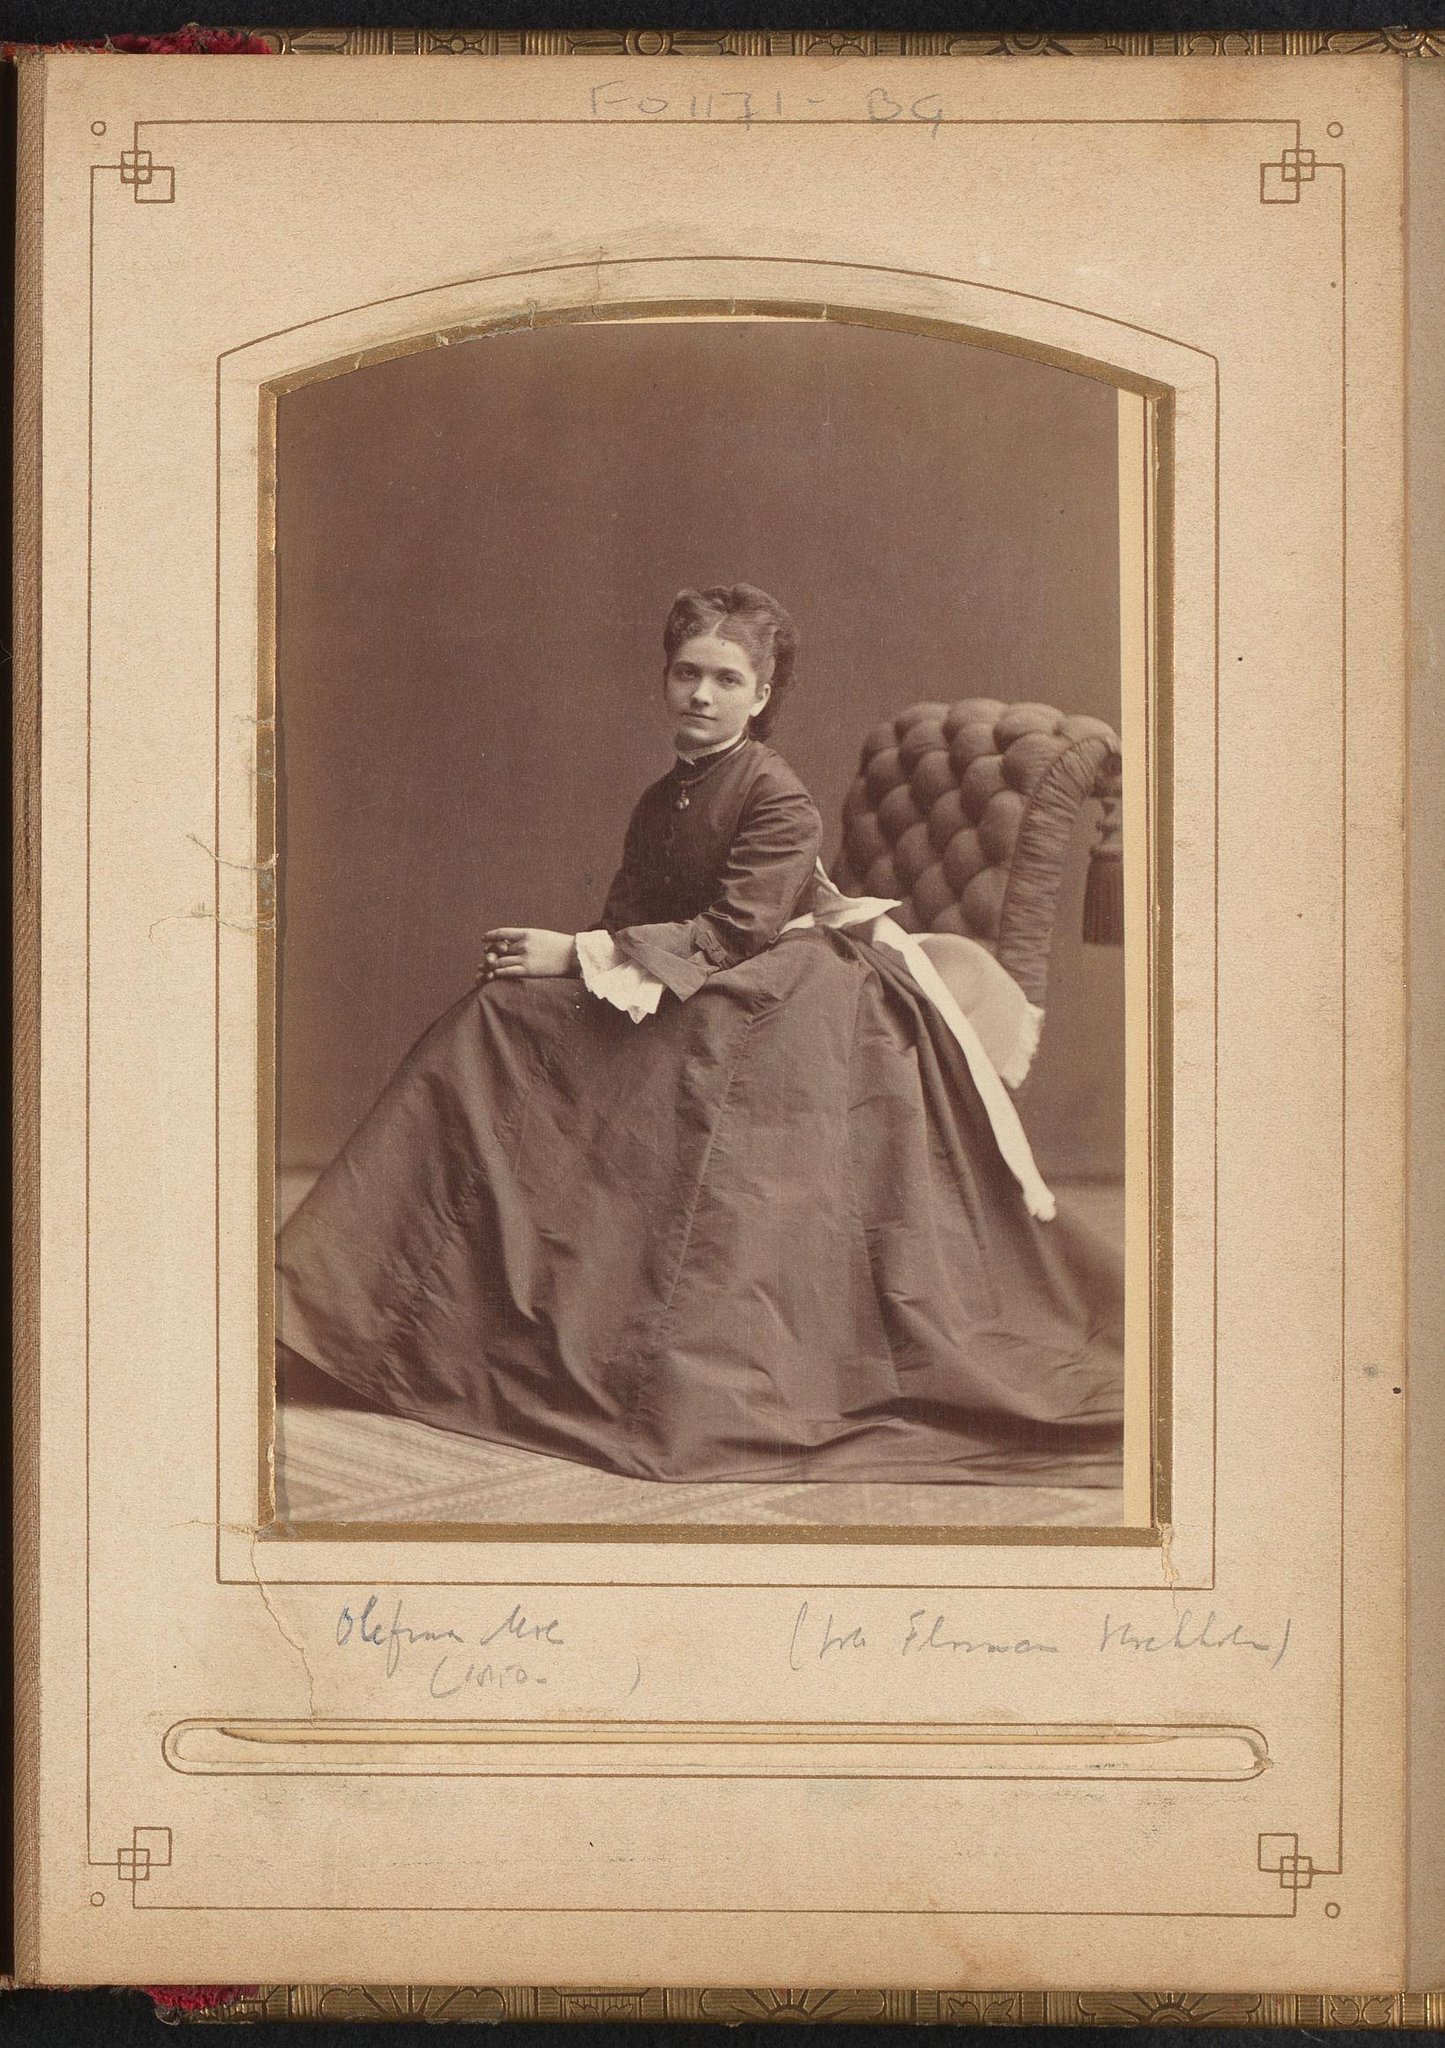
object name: album leaf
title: Portret van Olefine Moe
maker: gösta florman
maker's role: fotograaf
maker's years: 1831-1900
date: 1865-1890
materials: cardboard, photographic support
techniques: albumen print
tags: adult woman, opera-singer (female)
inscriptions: inscription: ‘Cabinet Portrait/ Gösta Florman Stockholm’, name: ‘Olefine Moe/ f 1750’, inscription: ‘Gosta Florman/ Stockholm/ 28 A Regiringsgatan 28A/ Odeon’